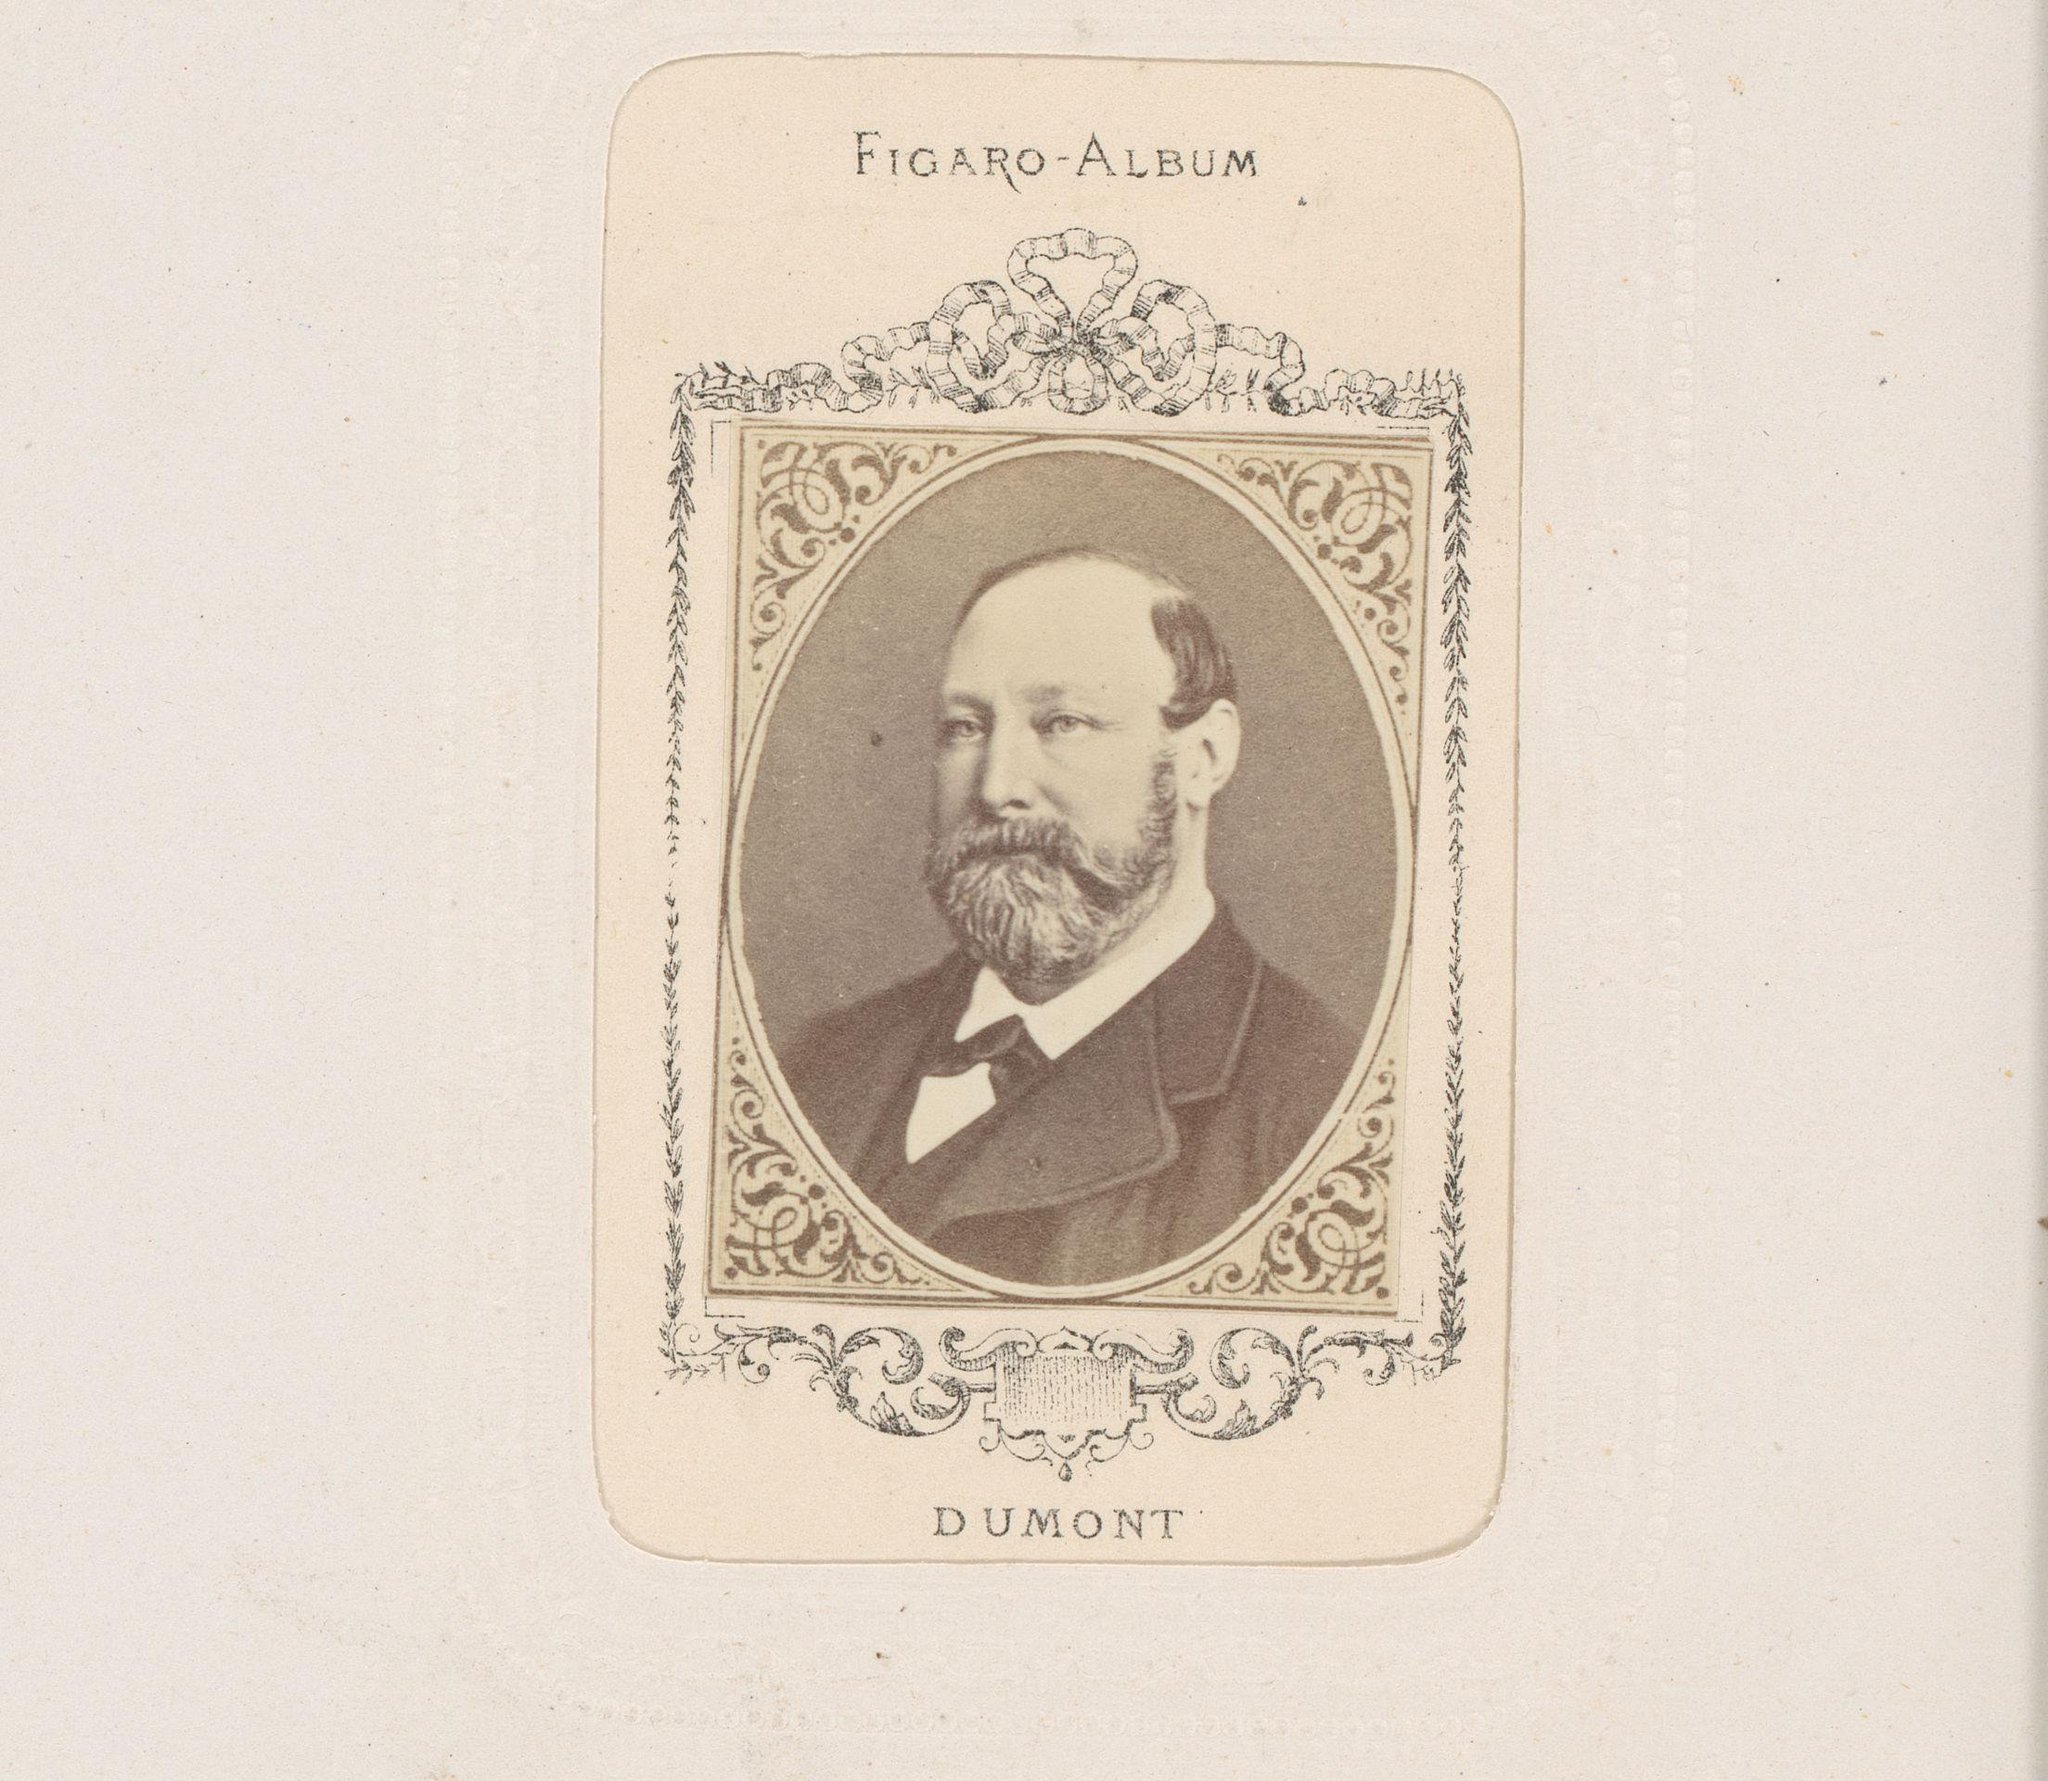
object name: photograph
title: Fotoreproductie van een portret van een man, aangeduid als Dumont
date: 1860-1900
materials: cardboard, photographic support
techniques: albumen print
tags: historical persons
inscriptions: inscription: ‘Figaro-Album/ Dumont/ Liébert Phot.’